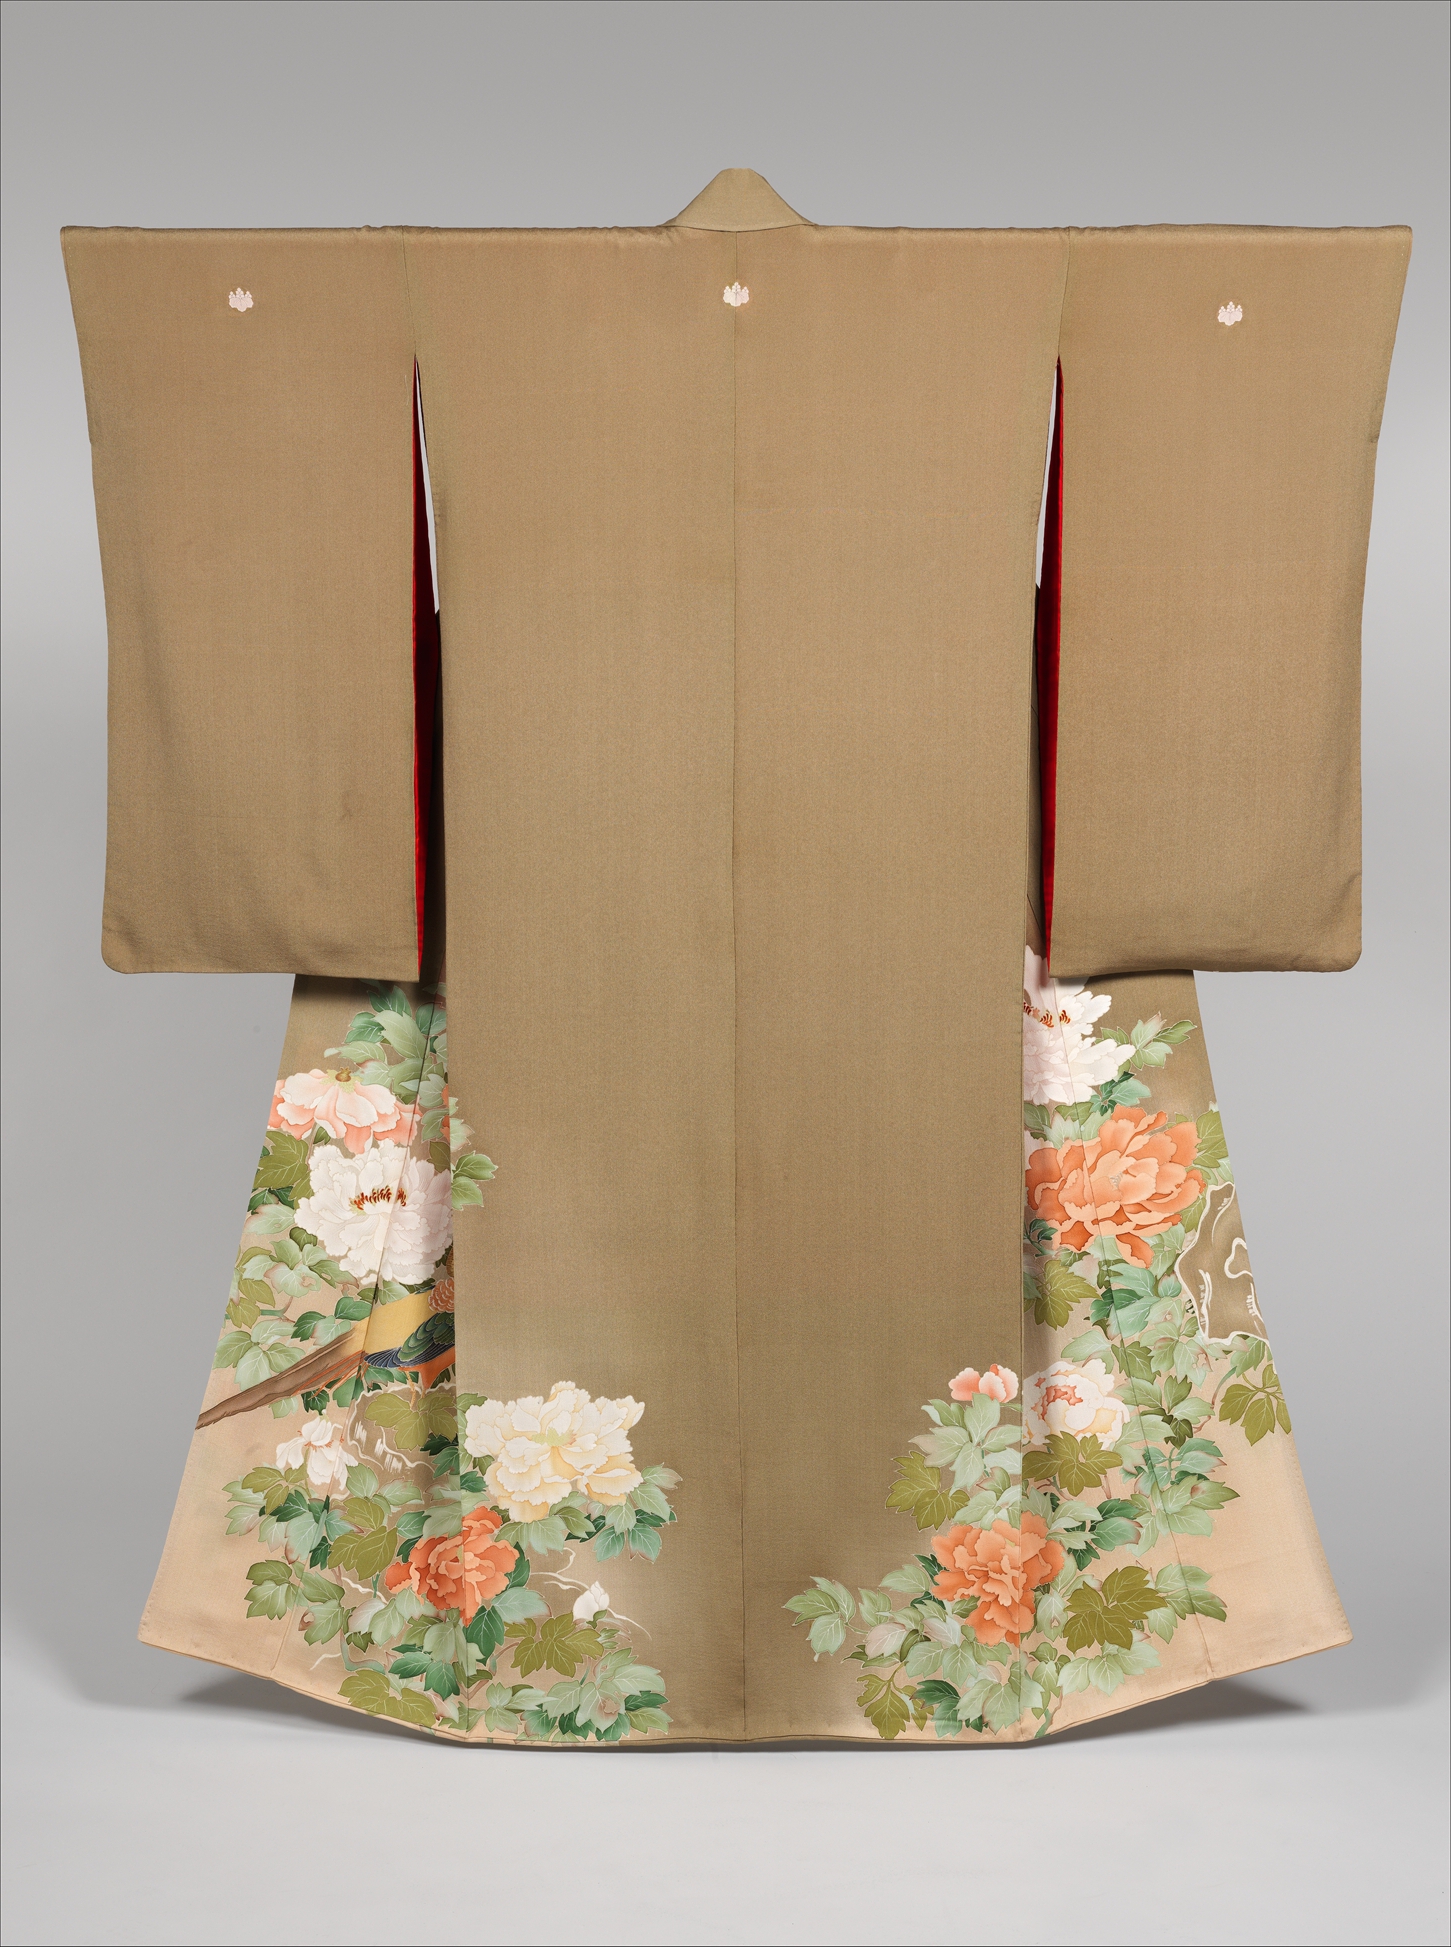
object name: kimono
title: Kimono with Pheasants amid Peonies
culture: japanese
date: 1901-1950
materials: paste, silk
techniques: embroidery, resist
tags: pheasants,peonies